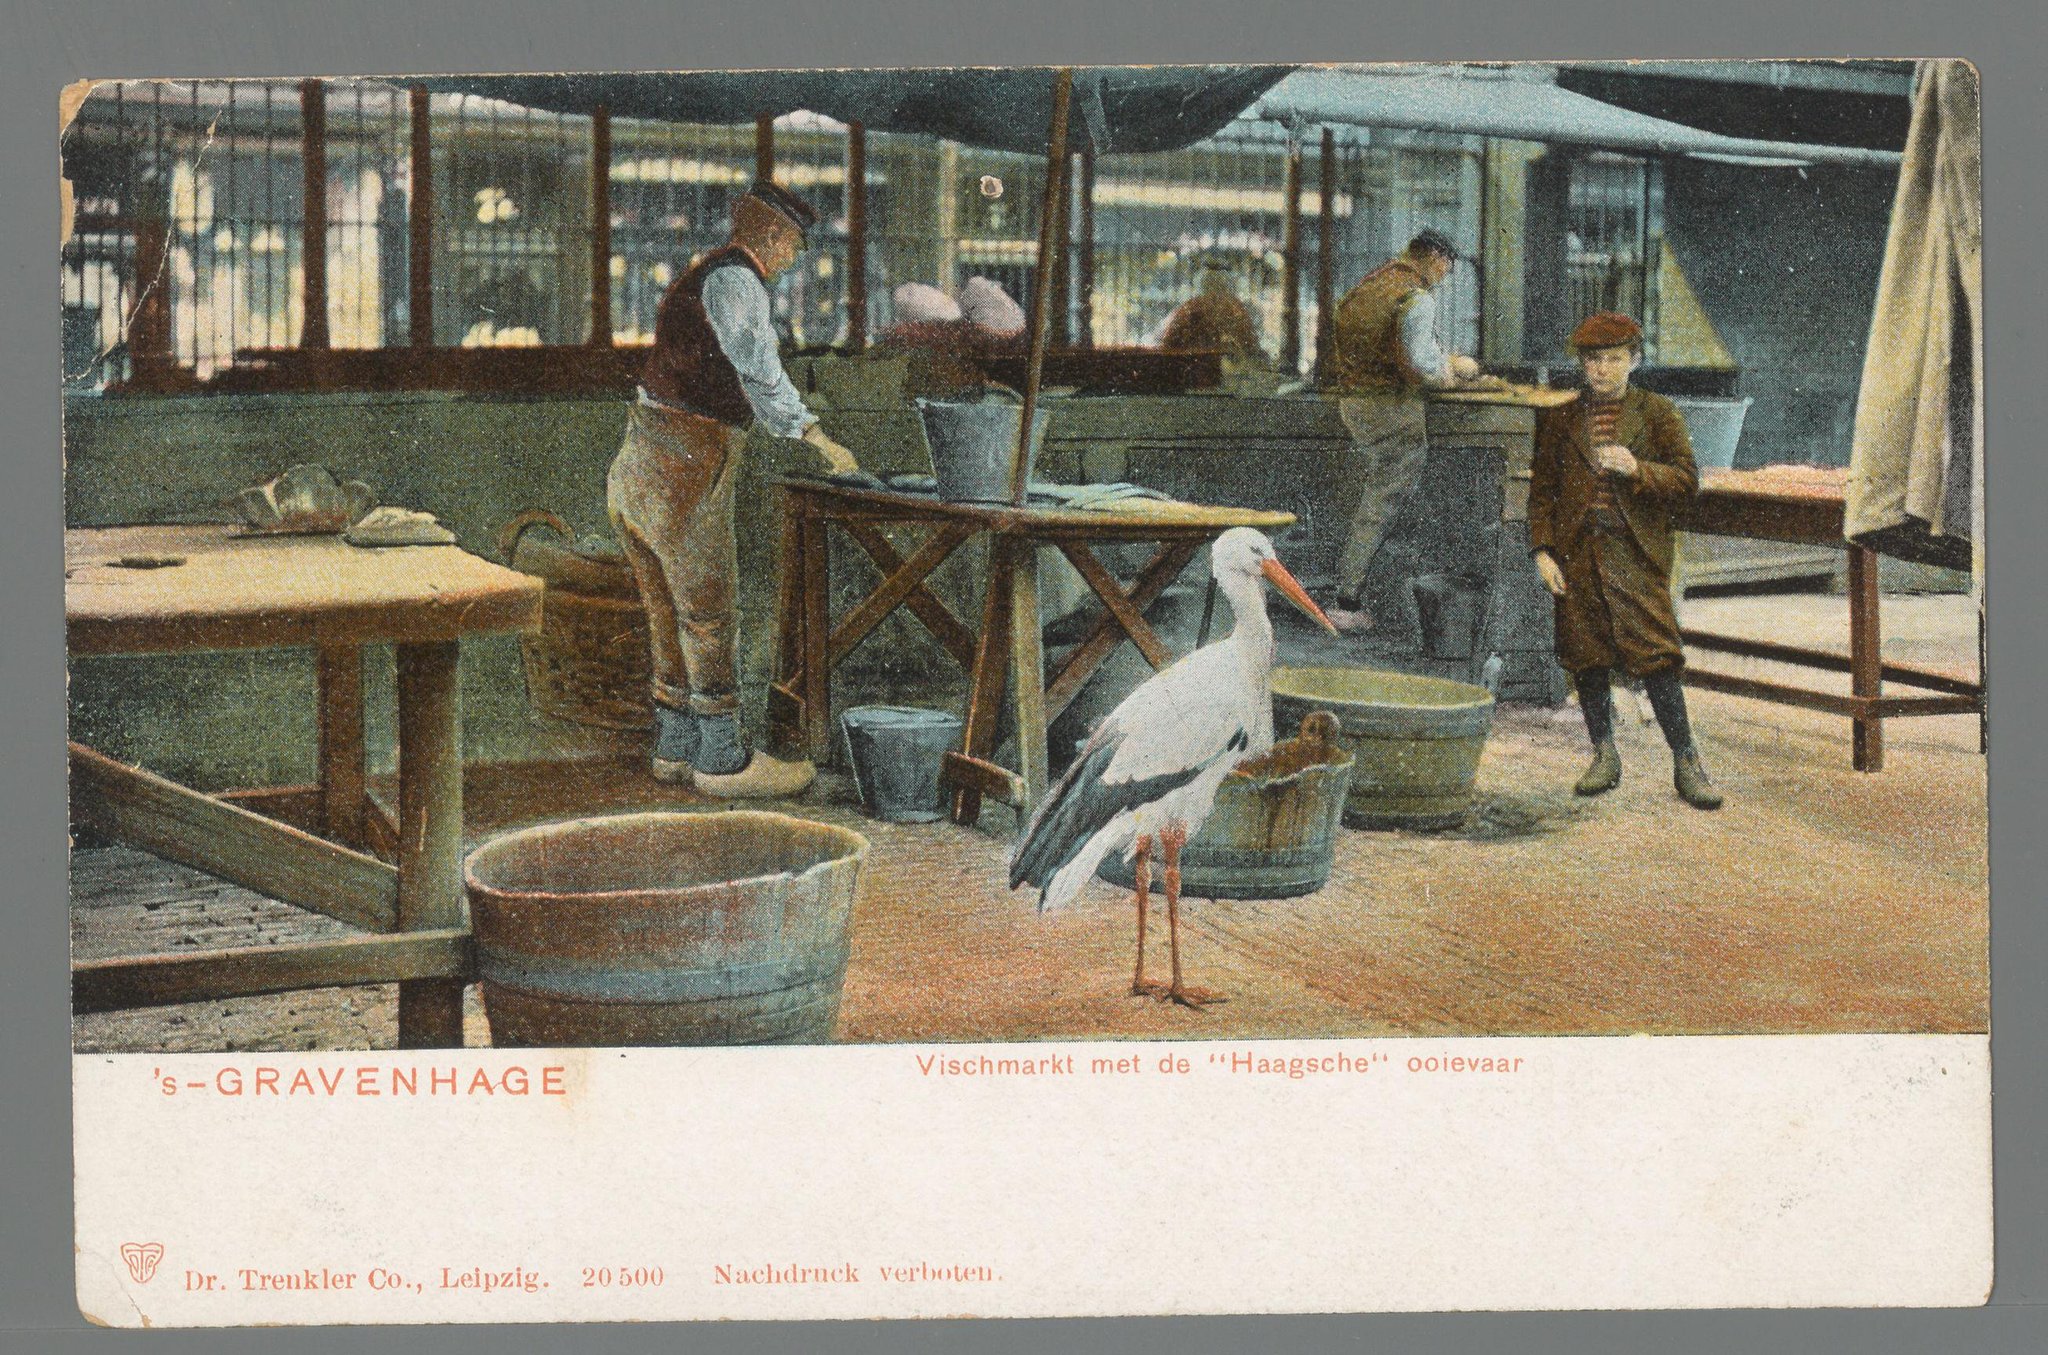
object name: ansichtkaart, prentbriefkaart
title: 's-Gravenhage. Vischmarkt met de "Haagsche" ooievaar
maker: Anonymous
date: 1897-1905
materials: cardboard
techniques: lithograph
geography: leipzig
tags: wooden container: barrel, cask, bucket, shore-birds and wading-birds: heron, fishes, stall, booth (~ market), the hague